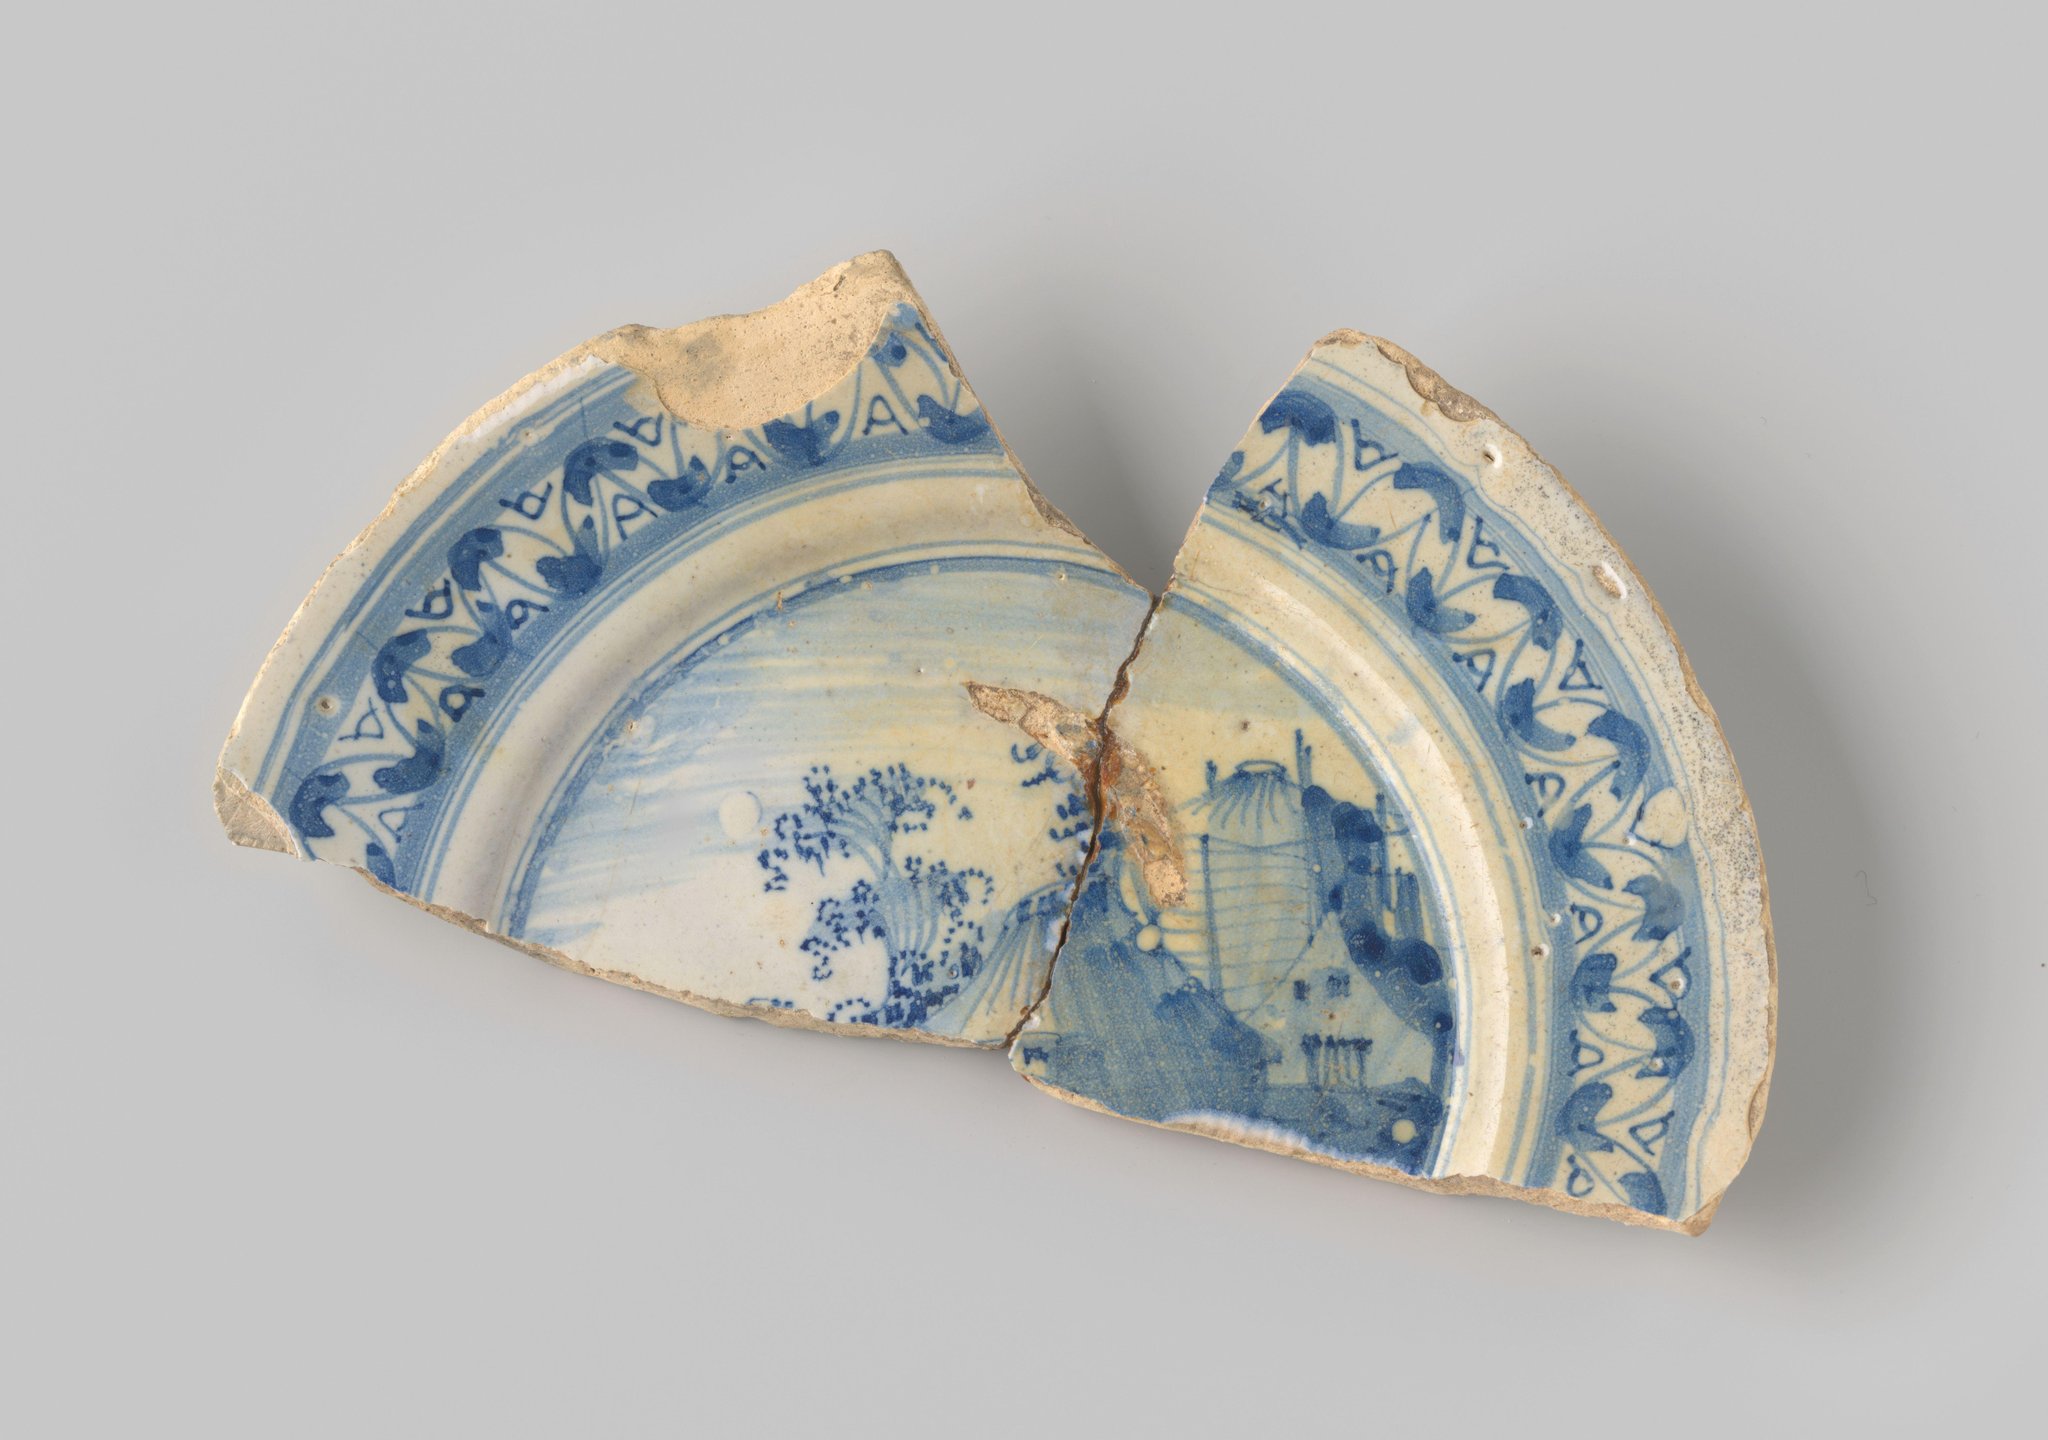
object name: fragment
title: Scherf van gelig bakkend aardewerk, voorzien van wit glazuur, aan de voorzijde voorzien van een sierrand en een schildering van een landschap met hooiberg en boerderijen in blauw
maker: Anonymous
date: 1600-1650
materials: earthenware, glaze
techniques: maiolica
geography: northern netherlands